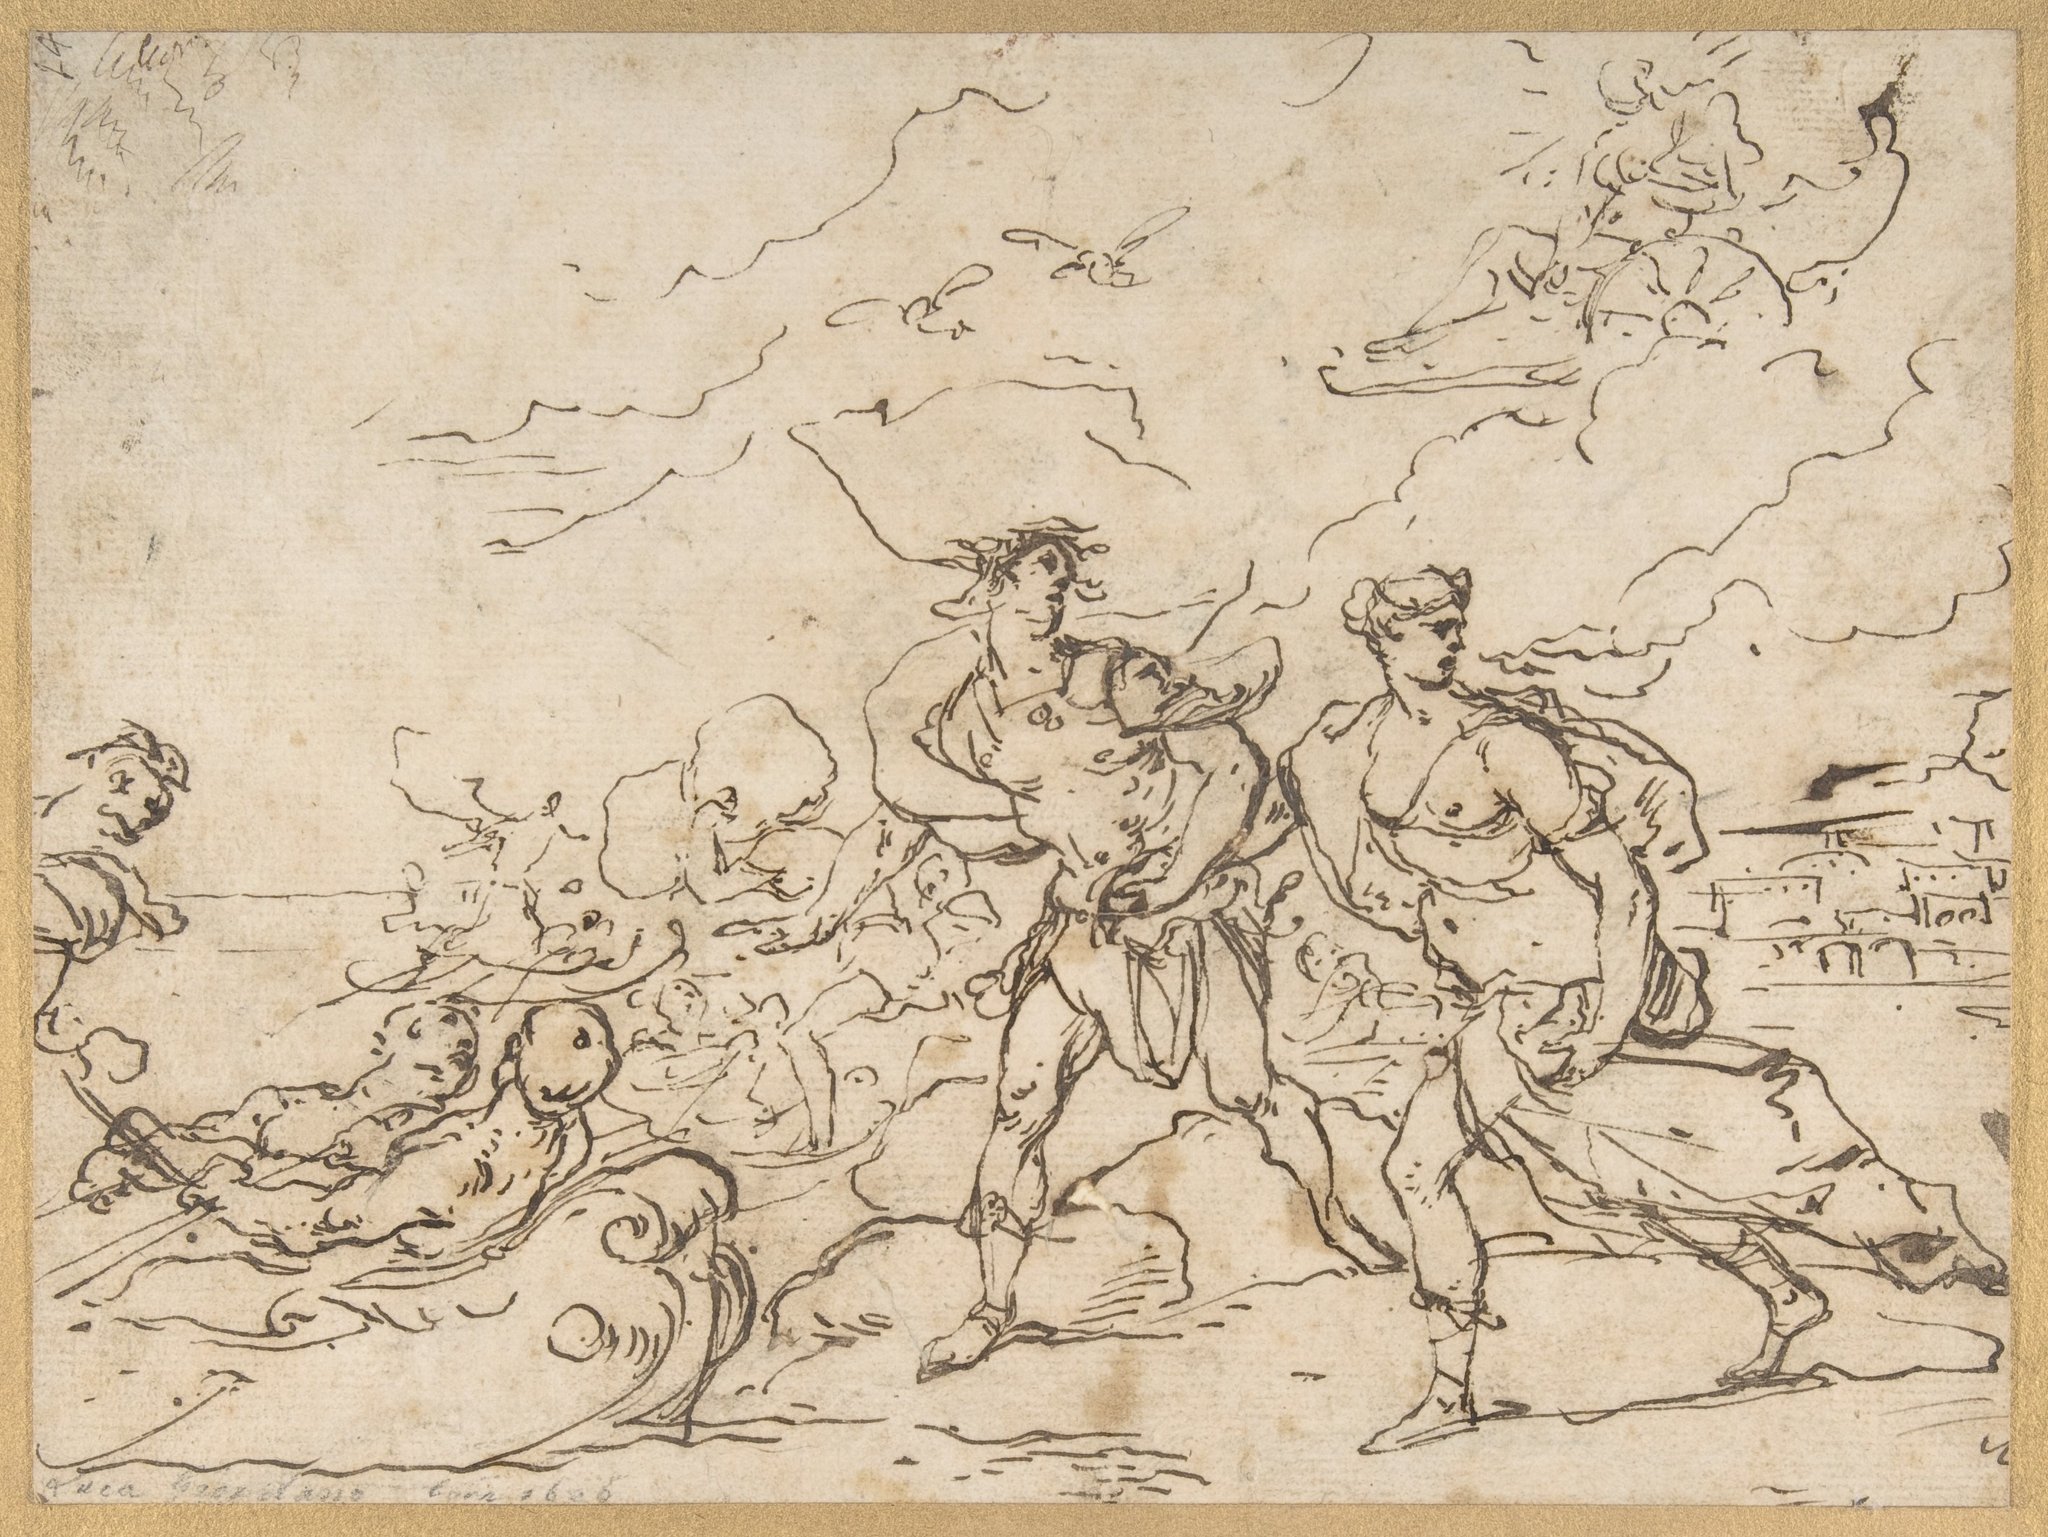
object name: drawing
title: The Abduction of Helen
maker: luca giordano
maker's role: artist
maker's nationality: italian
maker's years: 1634-1705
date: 1634-1705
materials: ink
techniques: pen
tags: men,helen